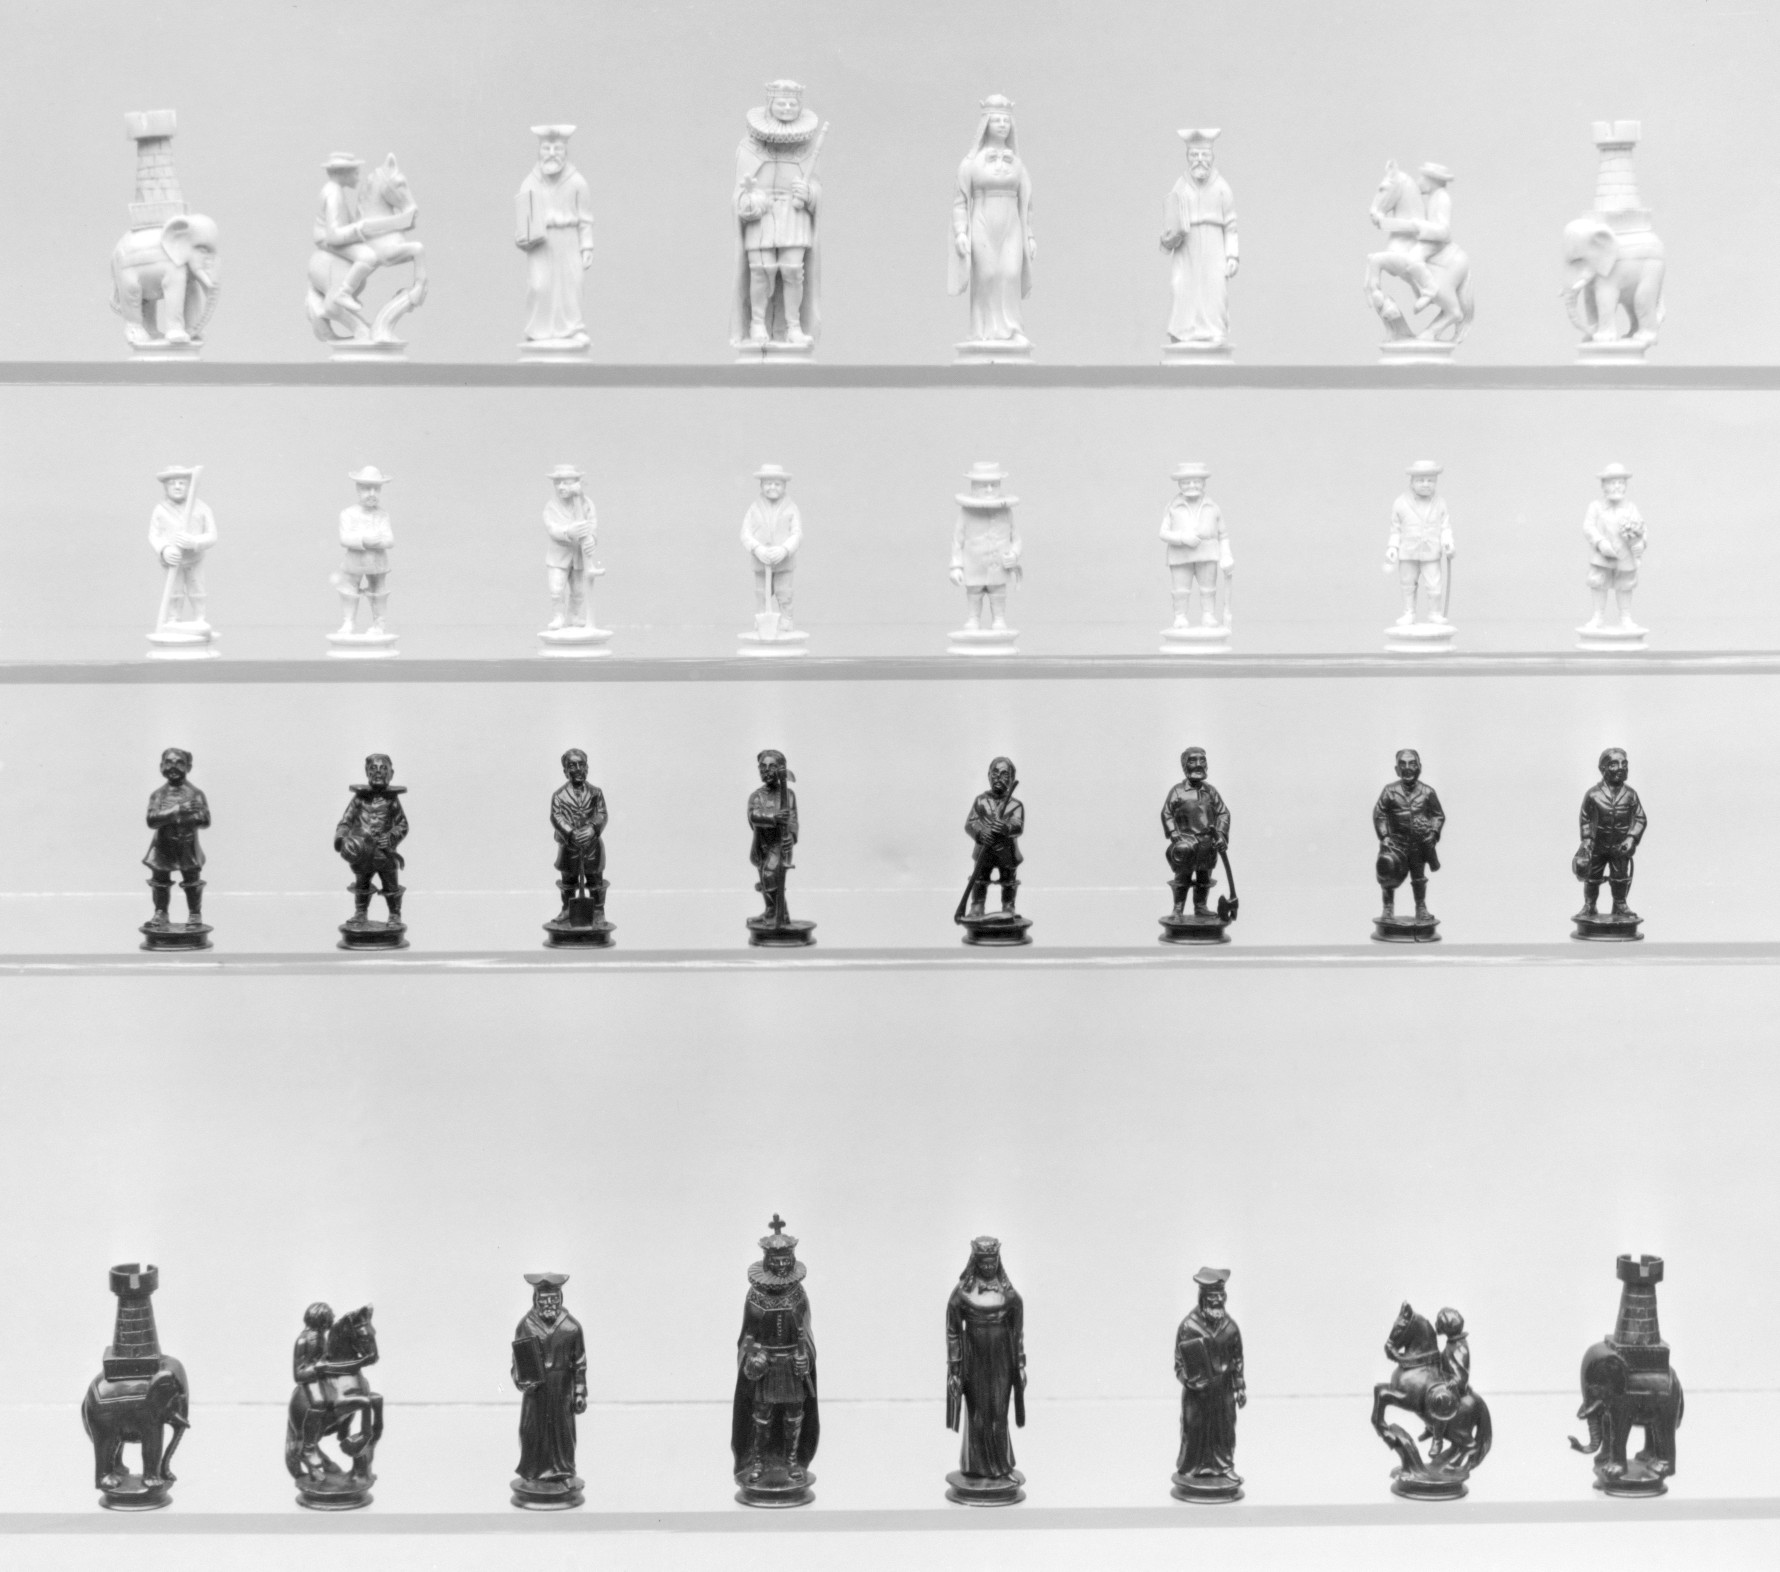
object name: chessman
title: Chessmen (32)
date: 1801-1900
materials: ivory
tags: chess,games